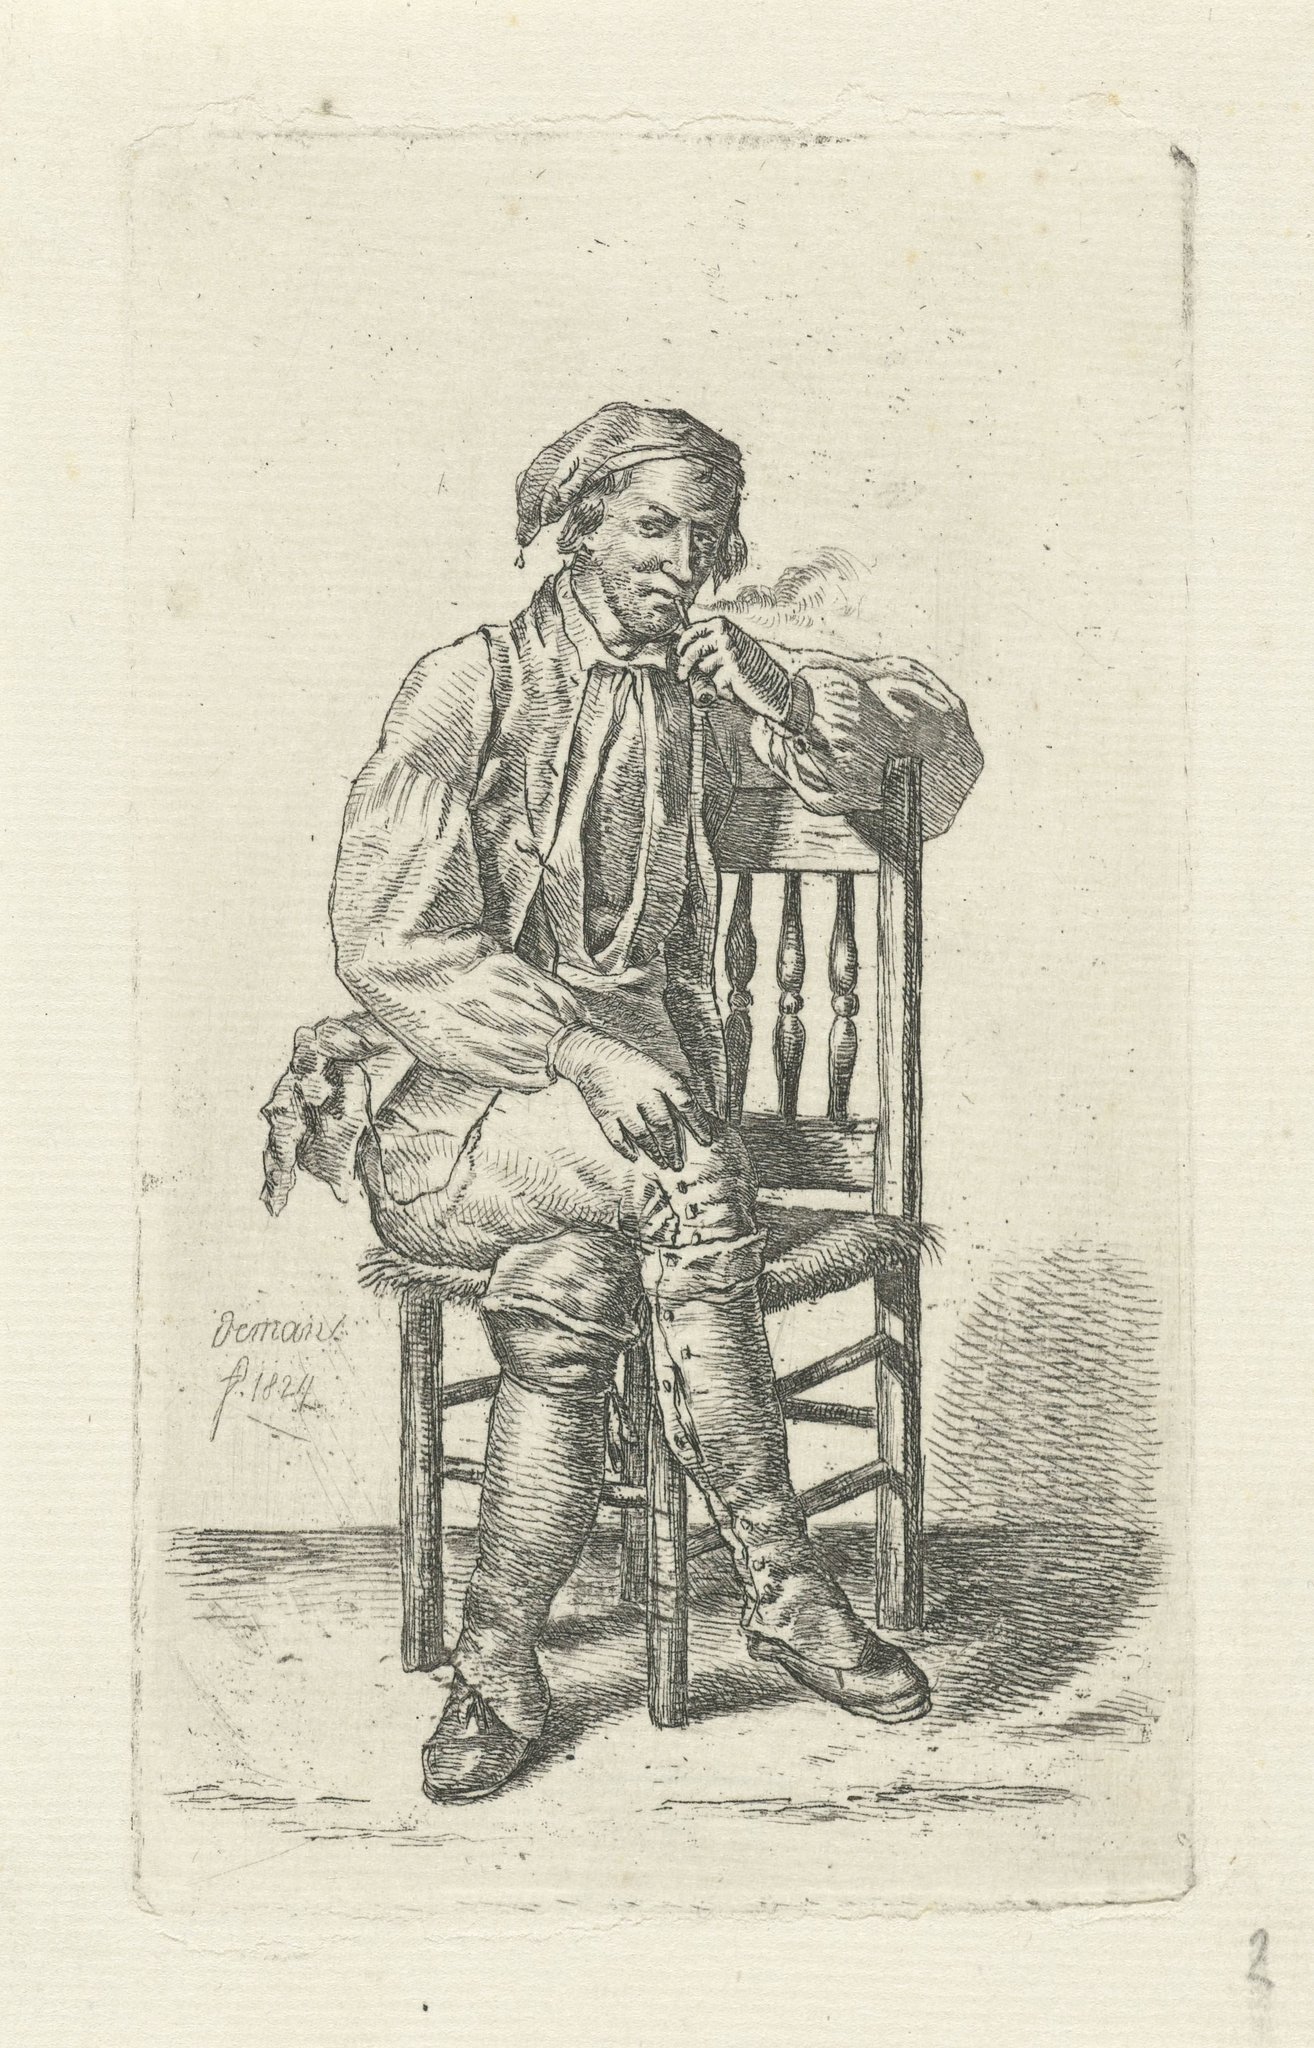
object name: print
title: Zittende man op een stoel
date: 1824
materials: paper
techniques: etching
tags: sitting figure (+ three-quarter view)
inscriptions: collector's mark: Lugt 2228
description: Man met zijn benen over elkaar zittend op een stoel.